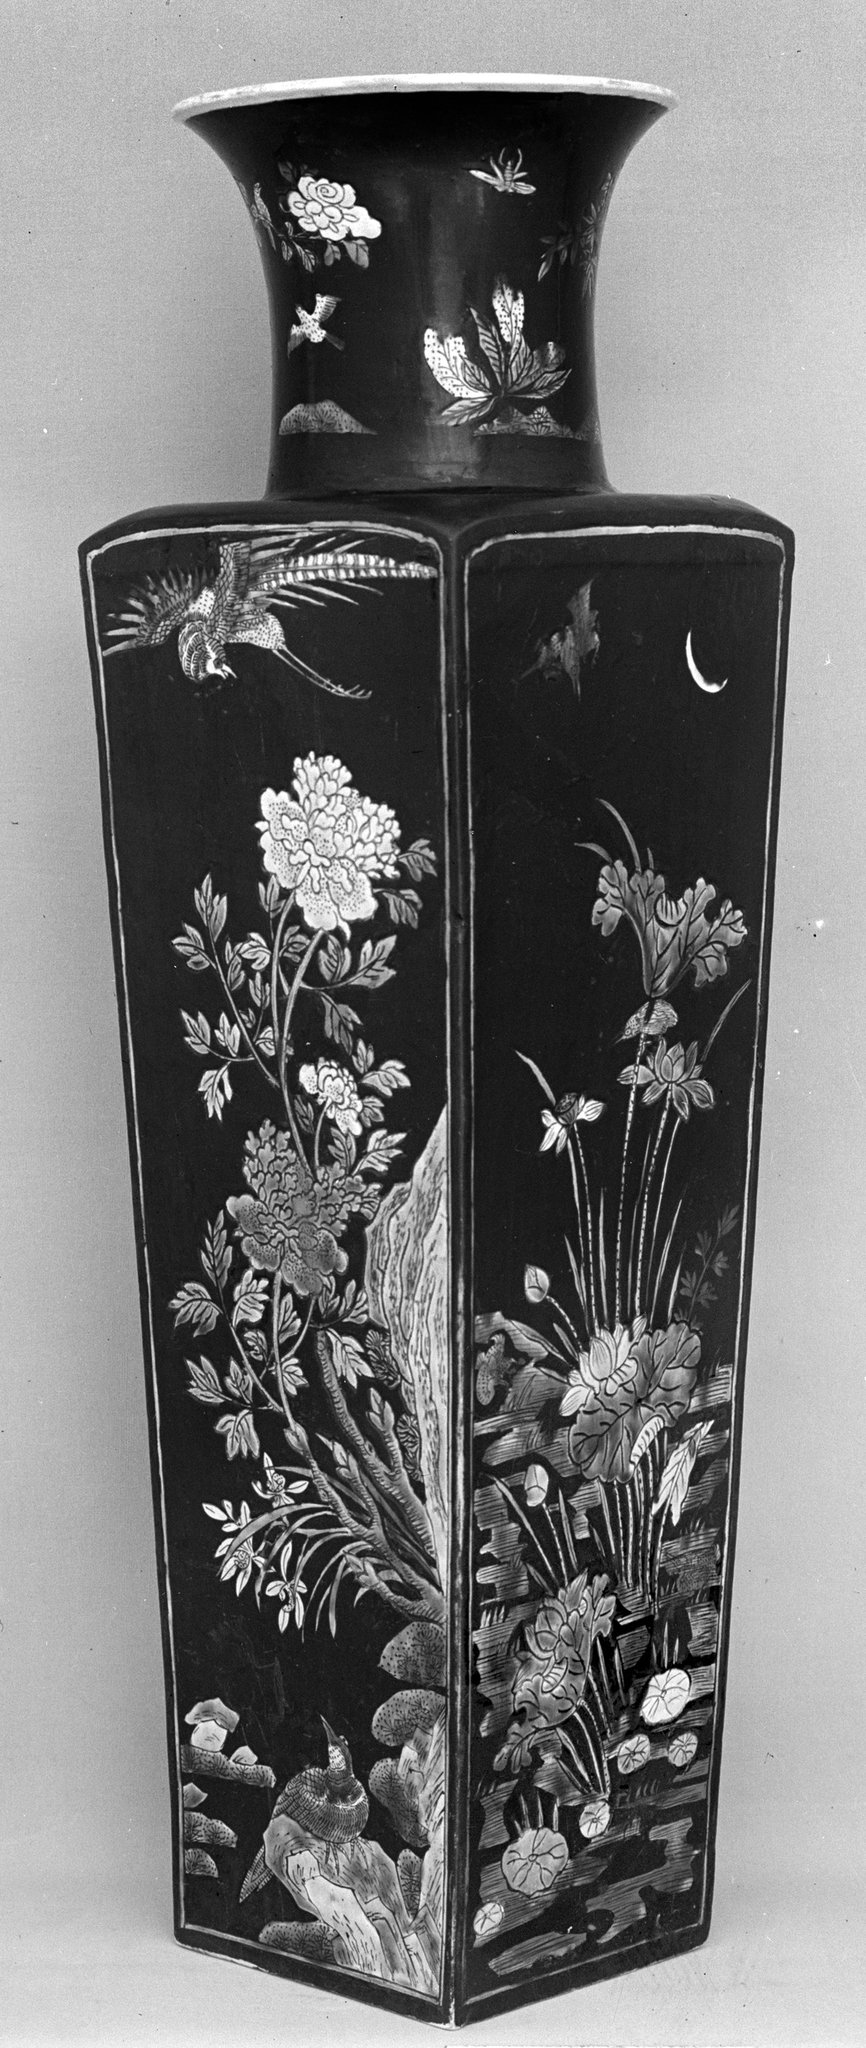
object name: vase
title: Square vase with birds and flowers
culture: chinese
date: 1801-1900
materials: enamel, porcelain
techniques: painting, polychrome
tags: birds,flowers